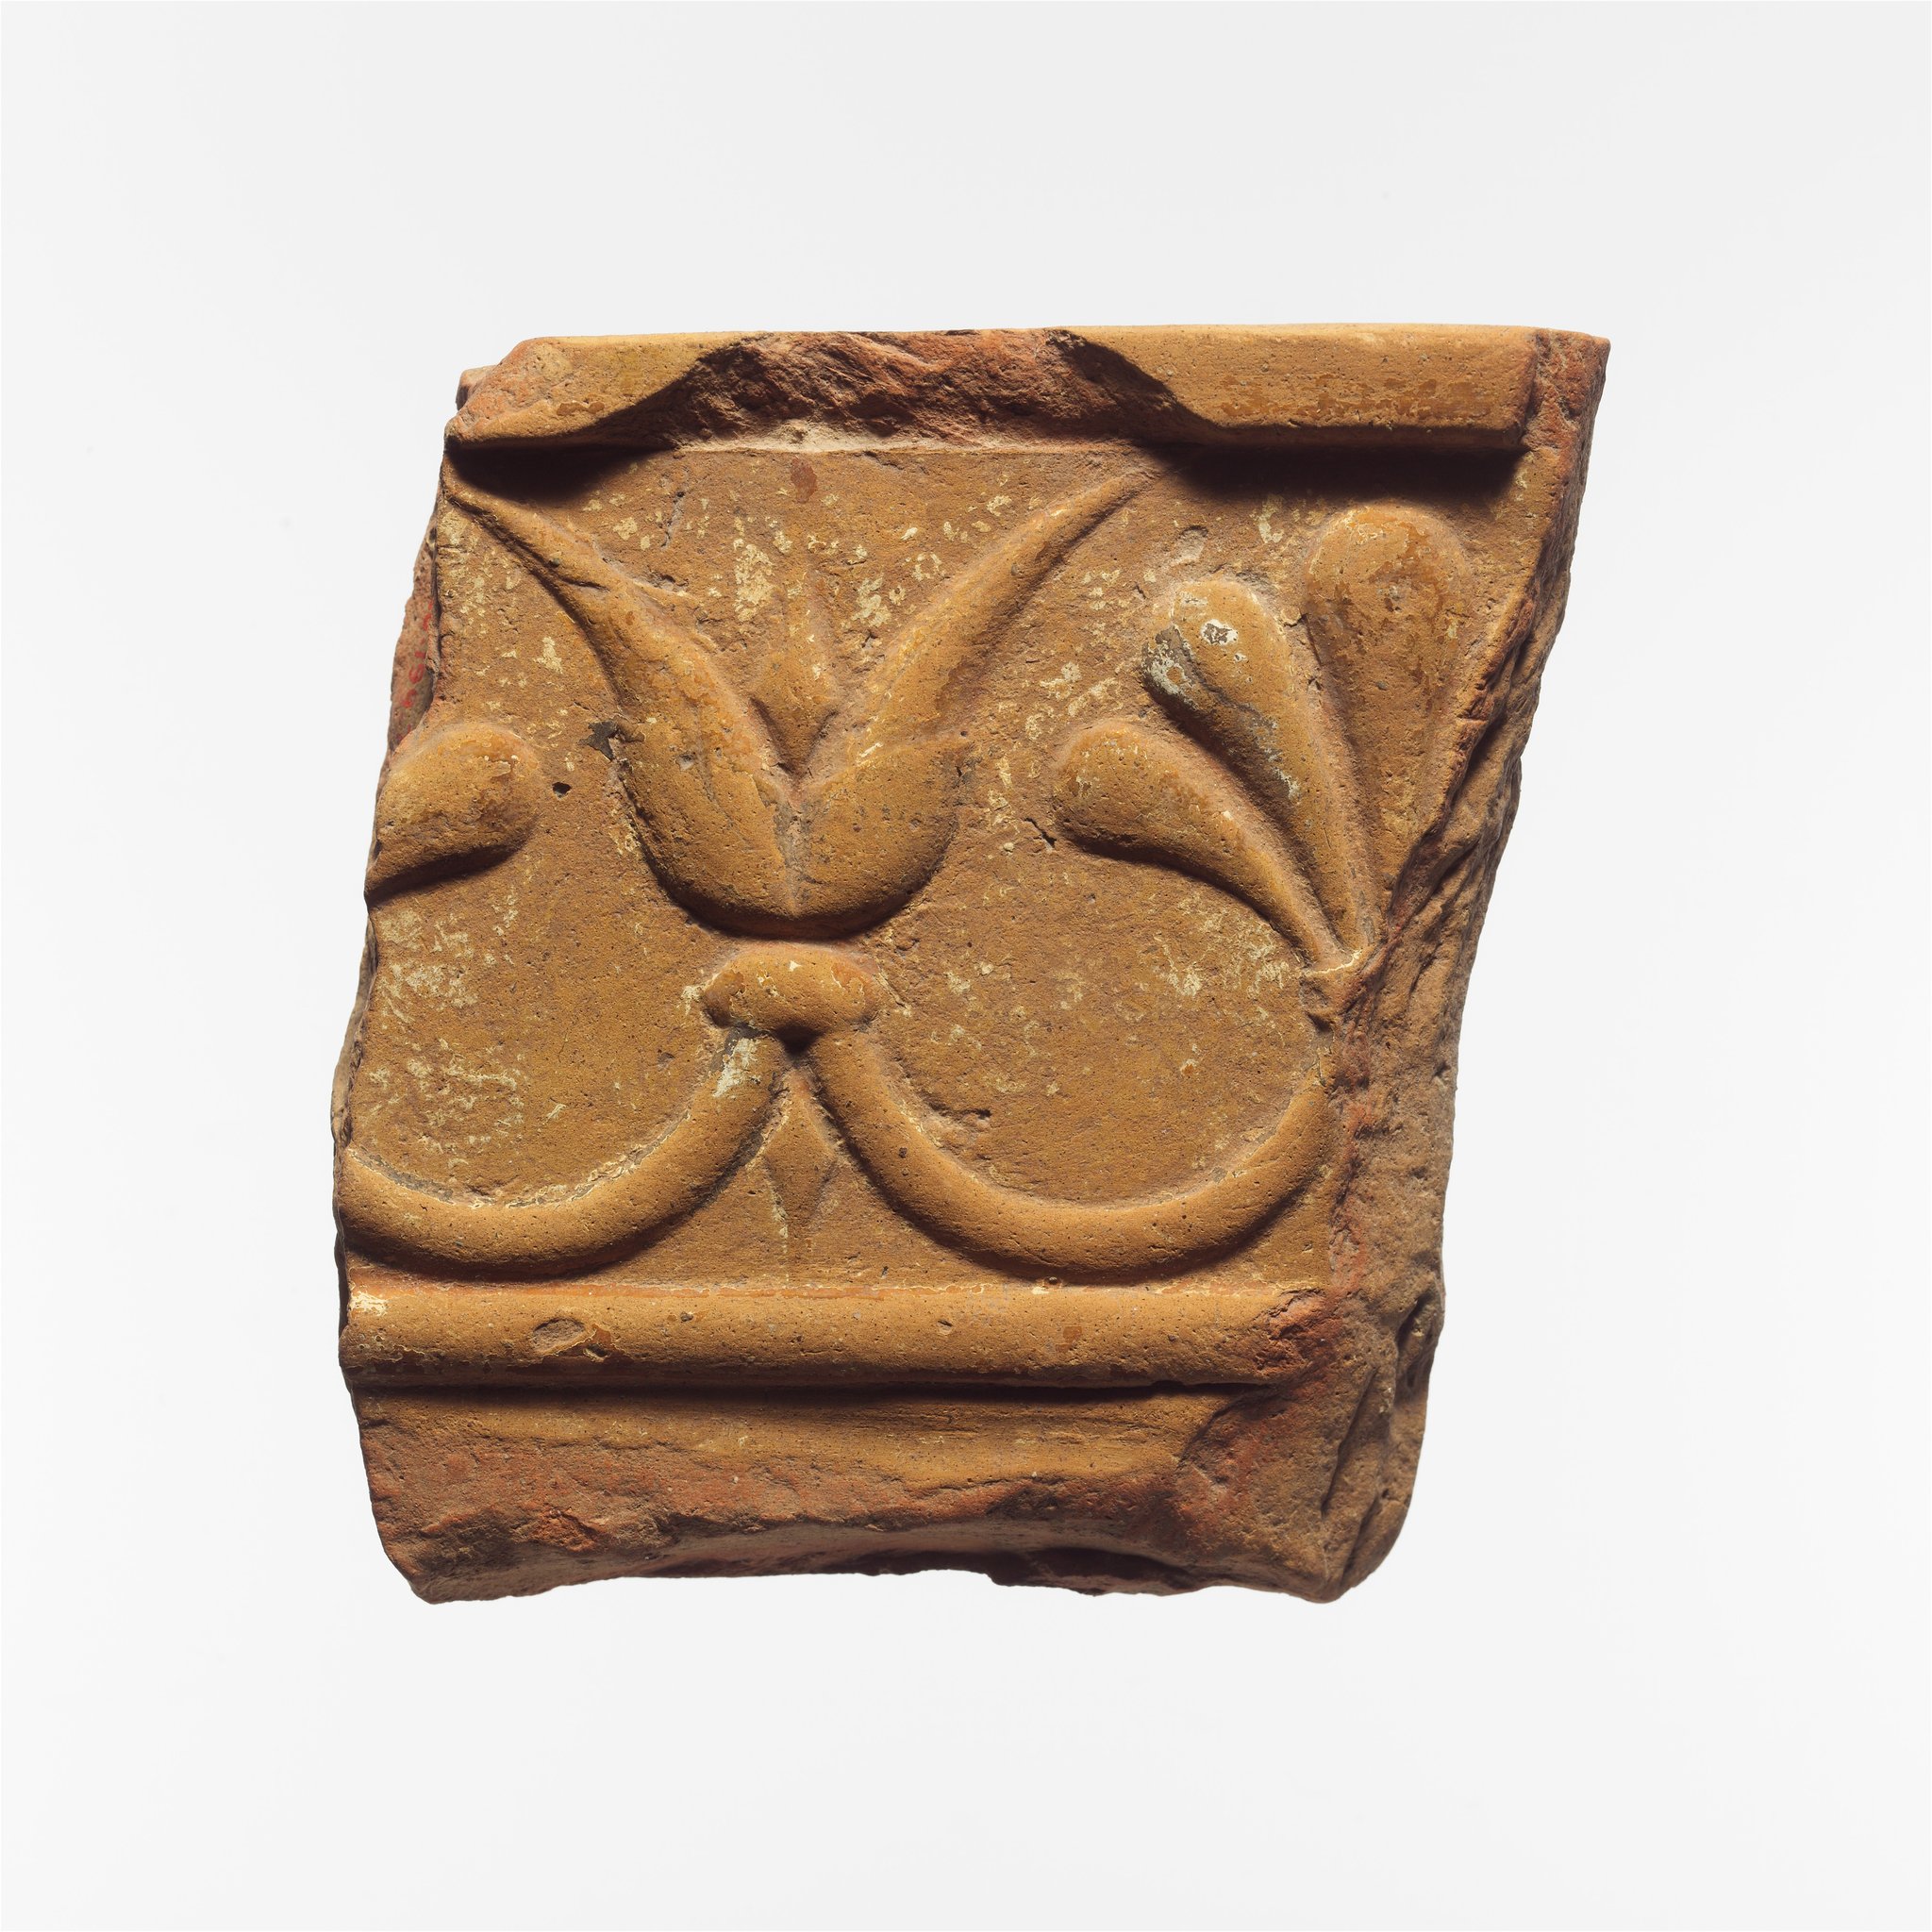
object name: tile with palmette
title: Fragment of a terracotta architectural tile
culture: lydian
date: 600-501 BCE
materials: terracotta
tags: lotuses